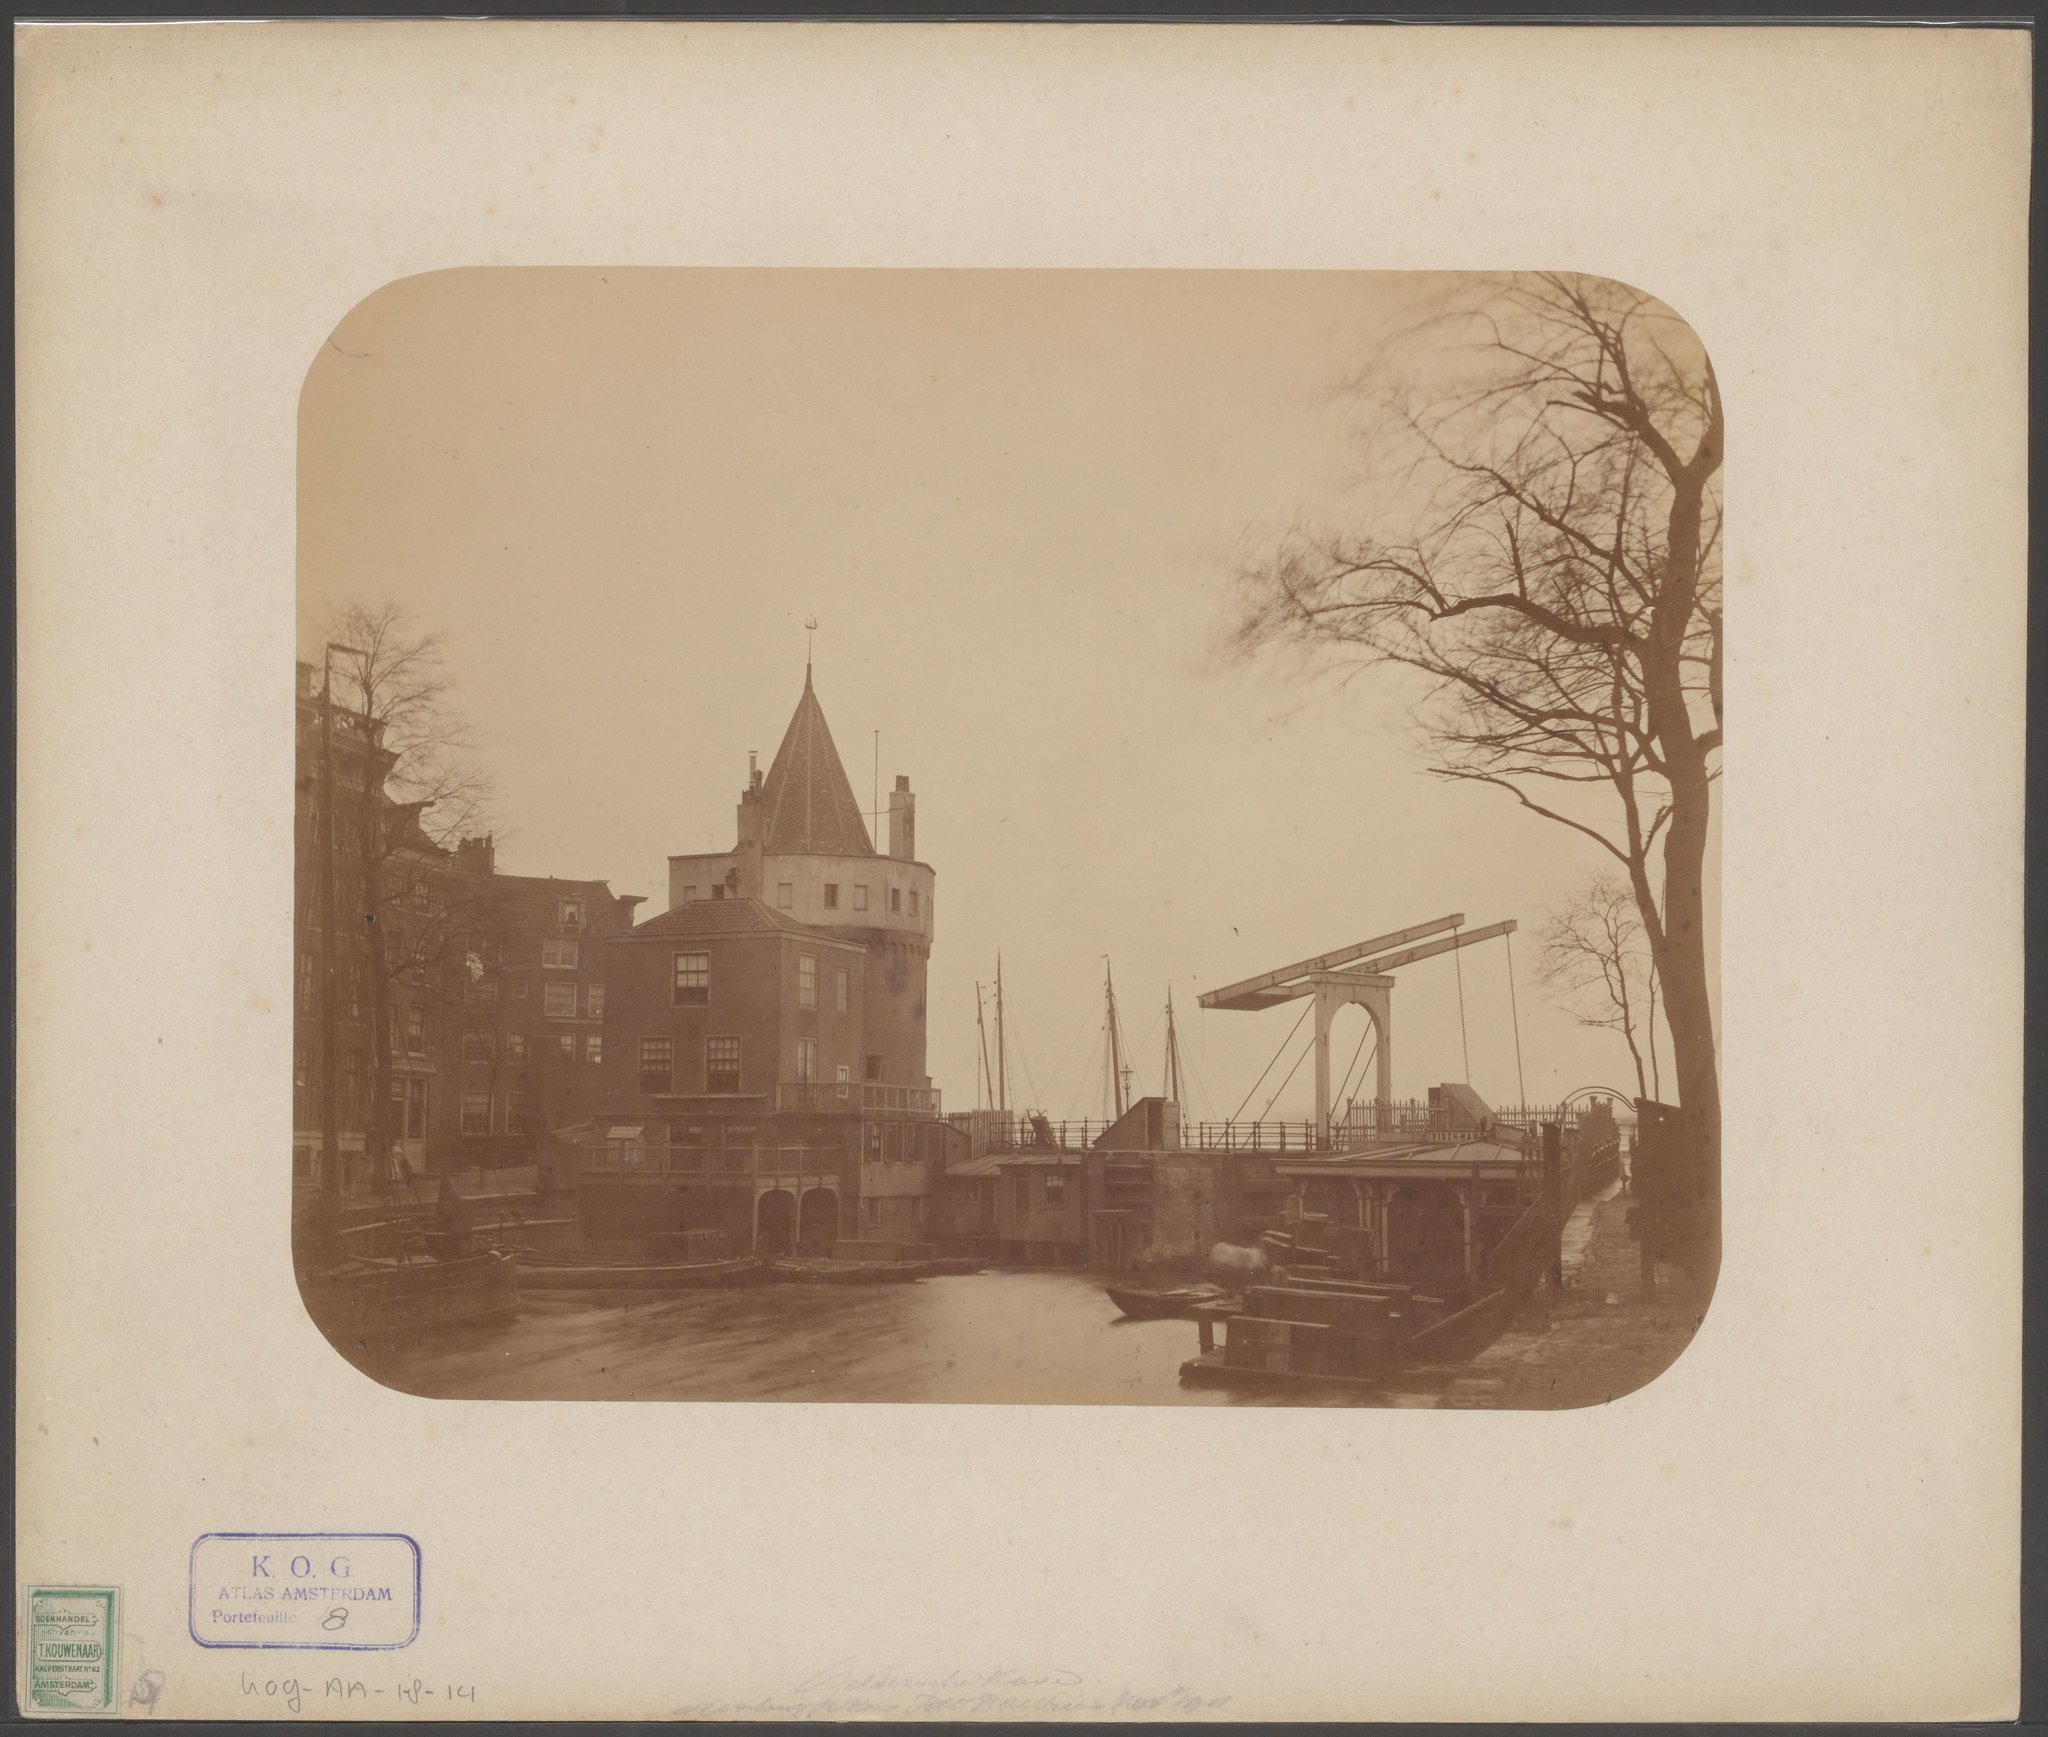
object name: photograph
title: Gezicht op de Schreierstoren aan de Geldersekade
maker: Anonymous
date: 1911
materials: cardboard, paper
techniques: albumen print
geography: amsterdam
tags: city-view in general; 'veduta', canal, bridge in city across river, canal, etc.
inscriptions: inscription: ‘Geldersche Kade / [...] Novr 1911’, collector's mark: ‘8’ Lugt 1641b, : ‘Boekhandel / van / T. Kouwenaar / Kalverstraat no 62 / Amsterdam’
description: Onderwerpsrubriek binnen de Atlas Amsterdam: Galerij Paleis voor Volksvlijt, Gebed zonder end, Geldersche Kade, Gravenstraat, Grimburgwal, Grimnessesluis, Groeneburgwal.